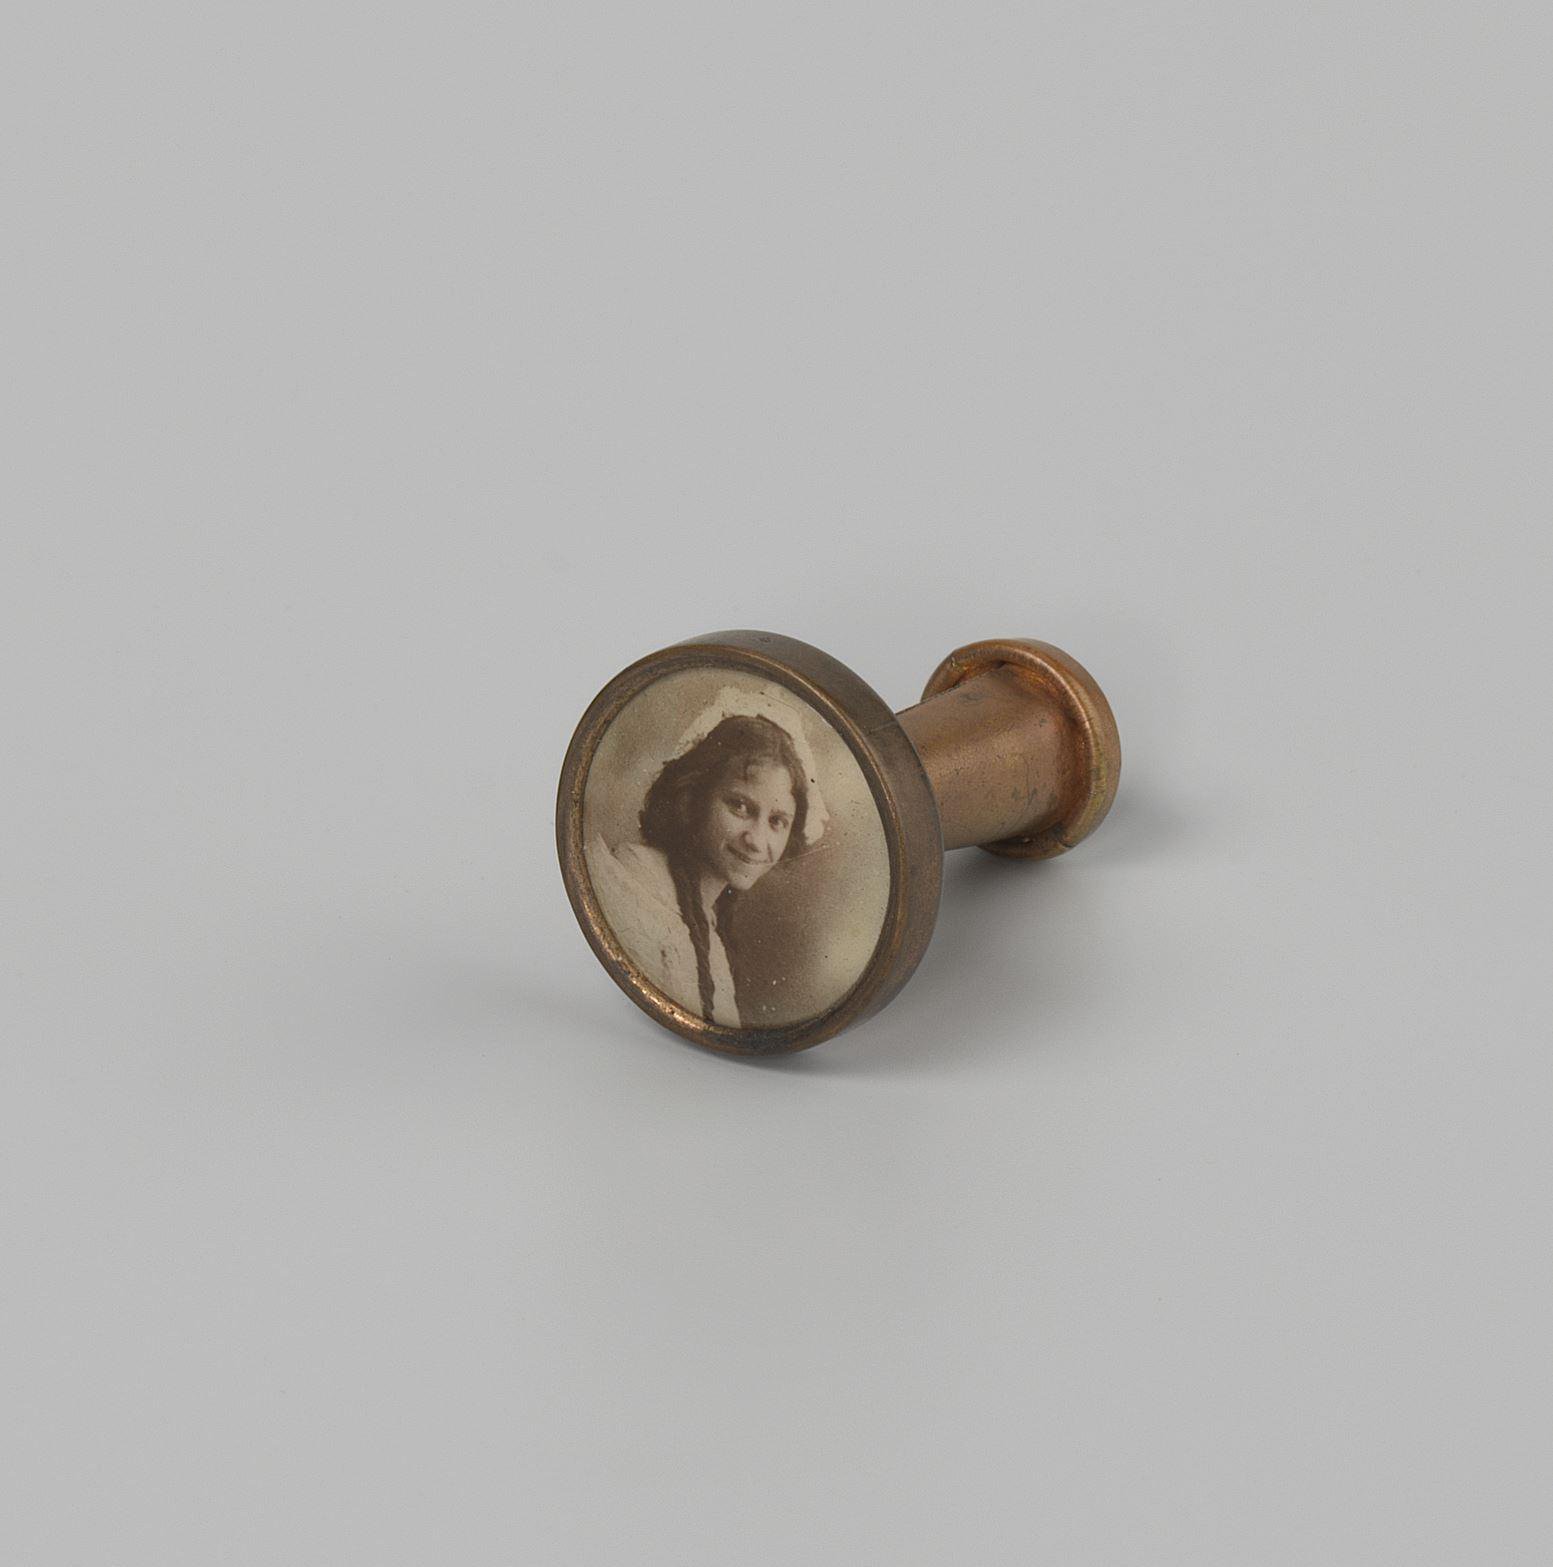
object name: photograph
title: Manchetknoop met foto van jonge vrouw met lachend gezicht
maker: Anonymous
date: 1900-1920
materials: brass, photographic support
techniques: photography